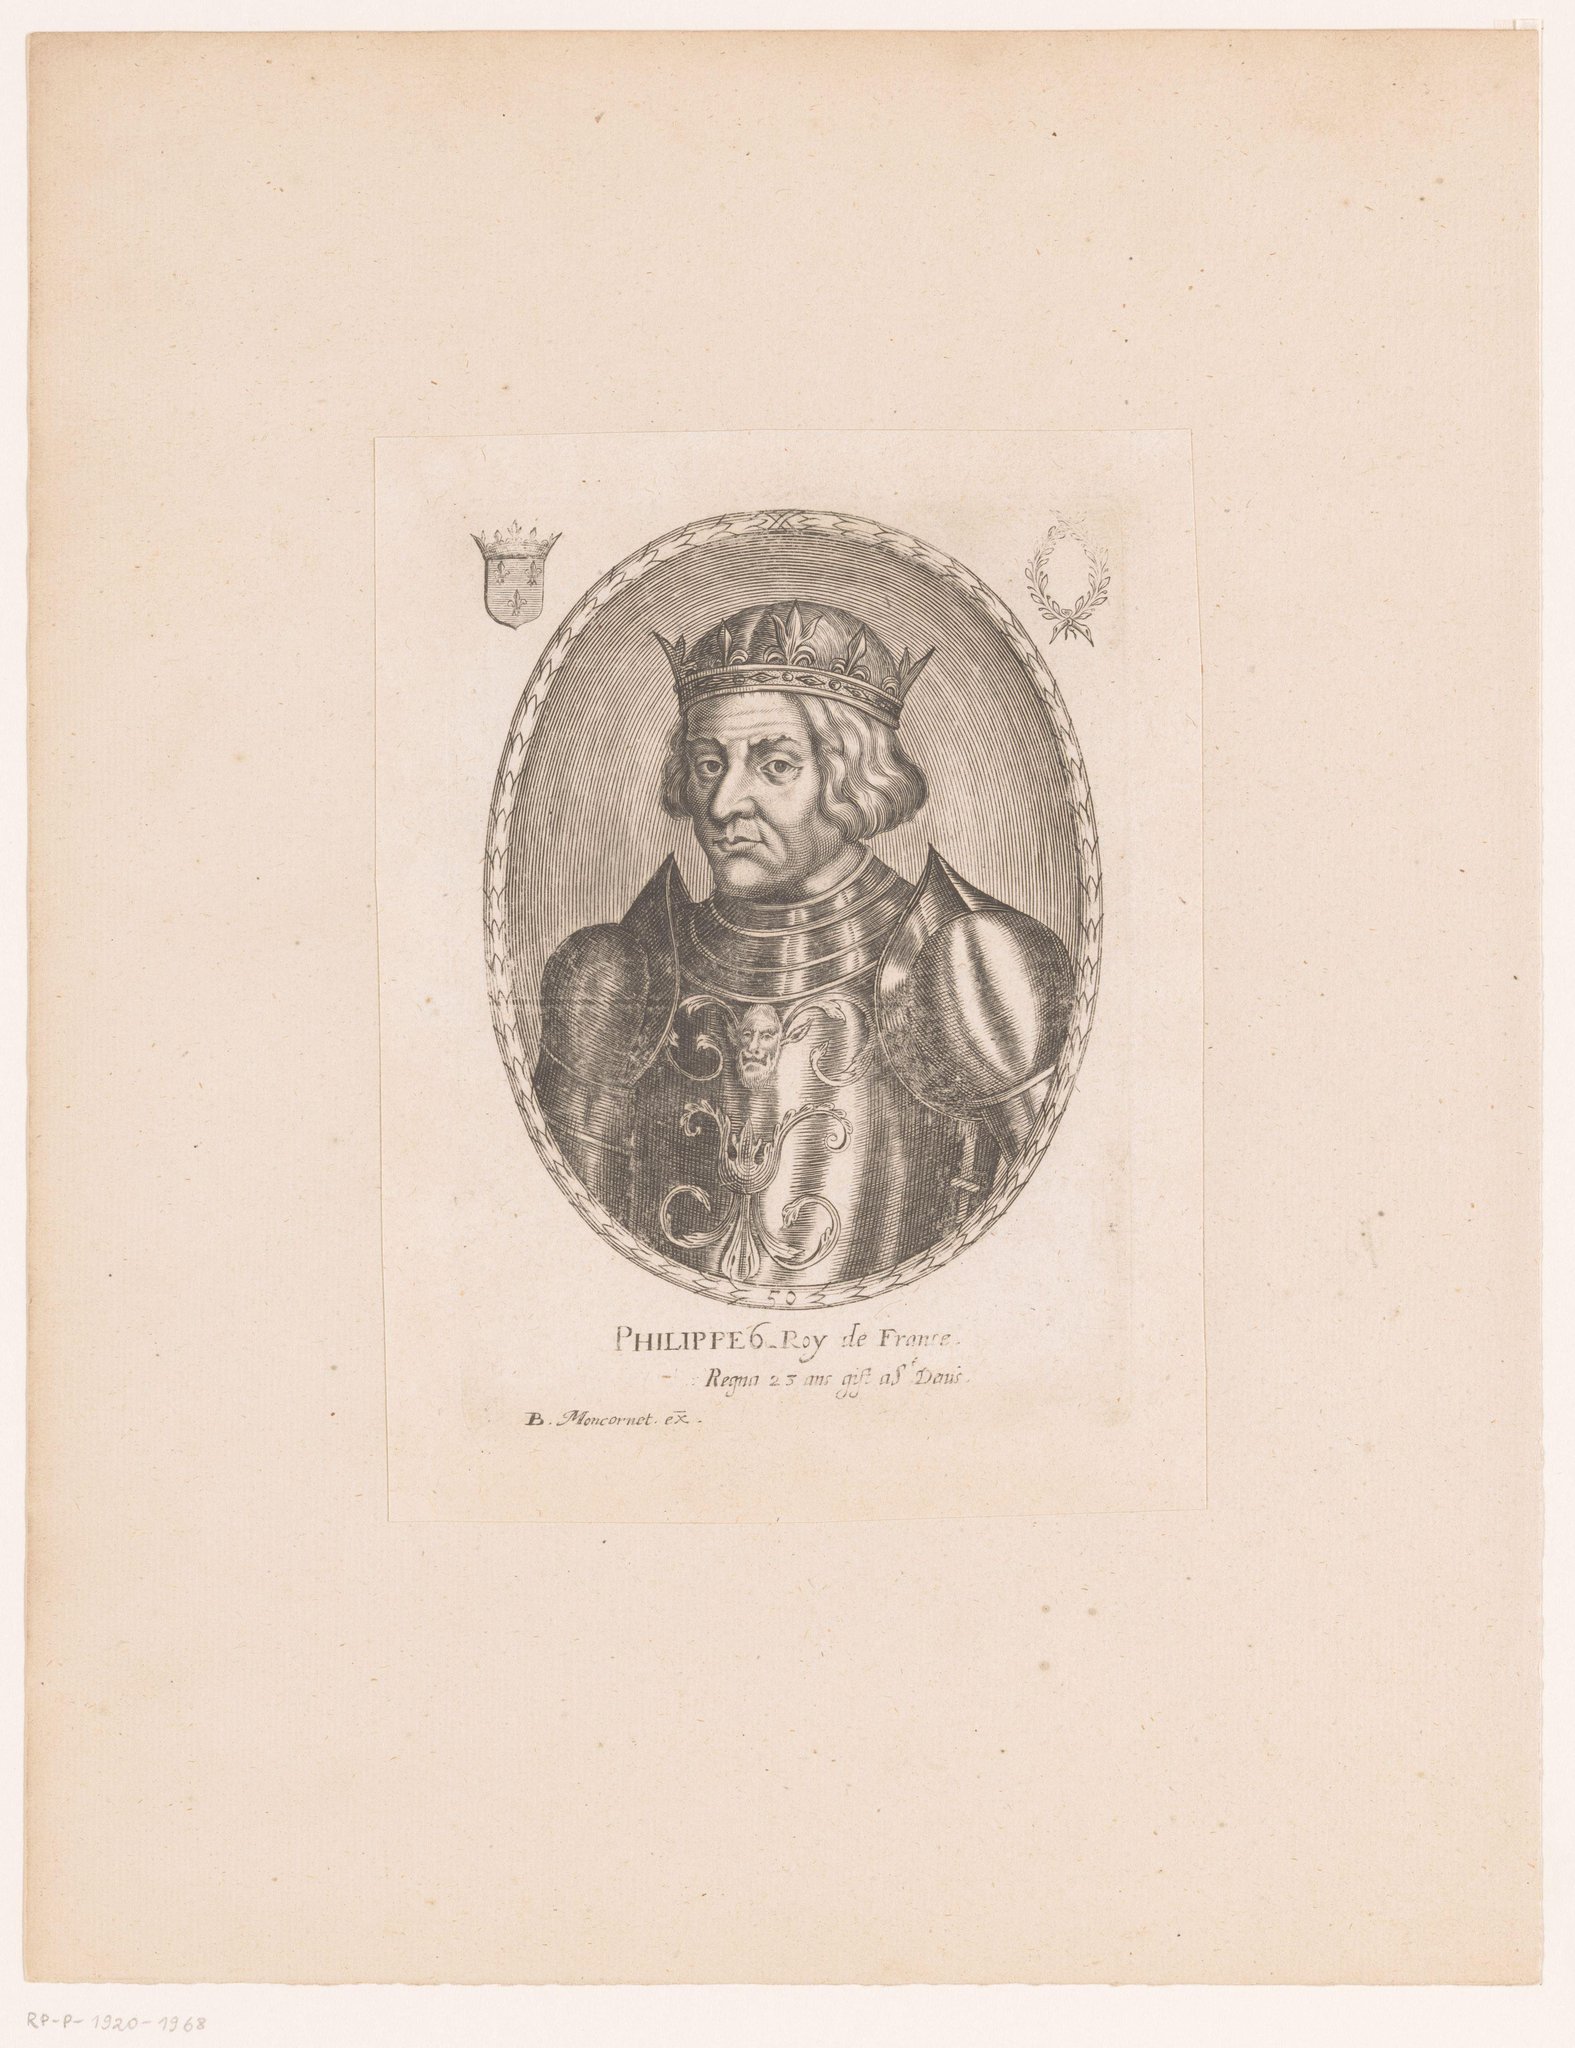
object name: print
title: Portret van Filips VI van Frankrijk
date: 1610-1668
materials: paper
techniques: engraving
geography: paris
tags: historical persons, king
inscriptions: collector's mark: Lugt 2228